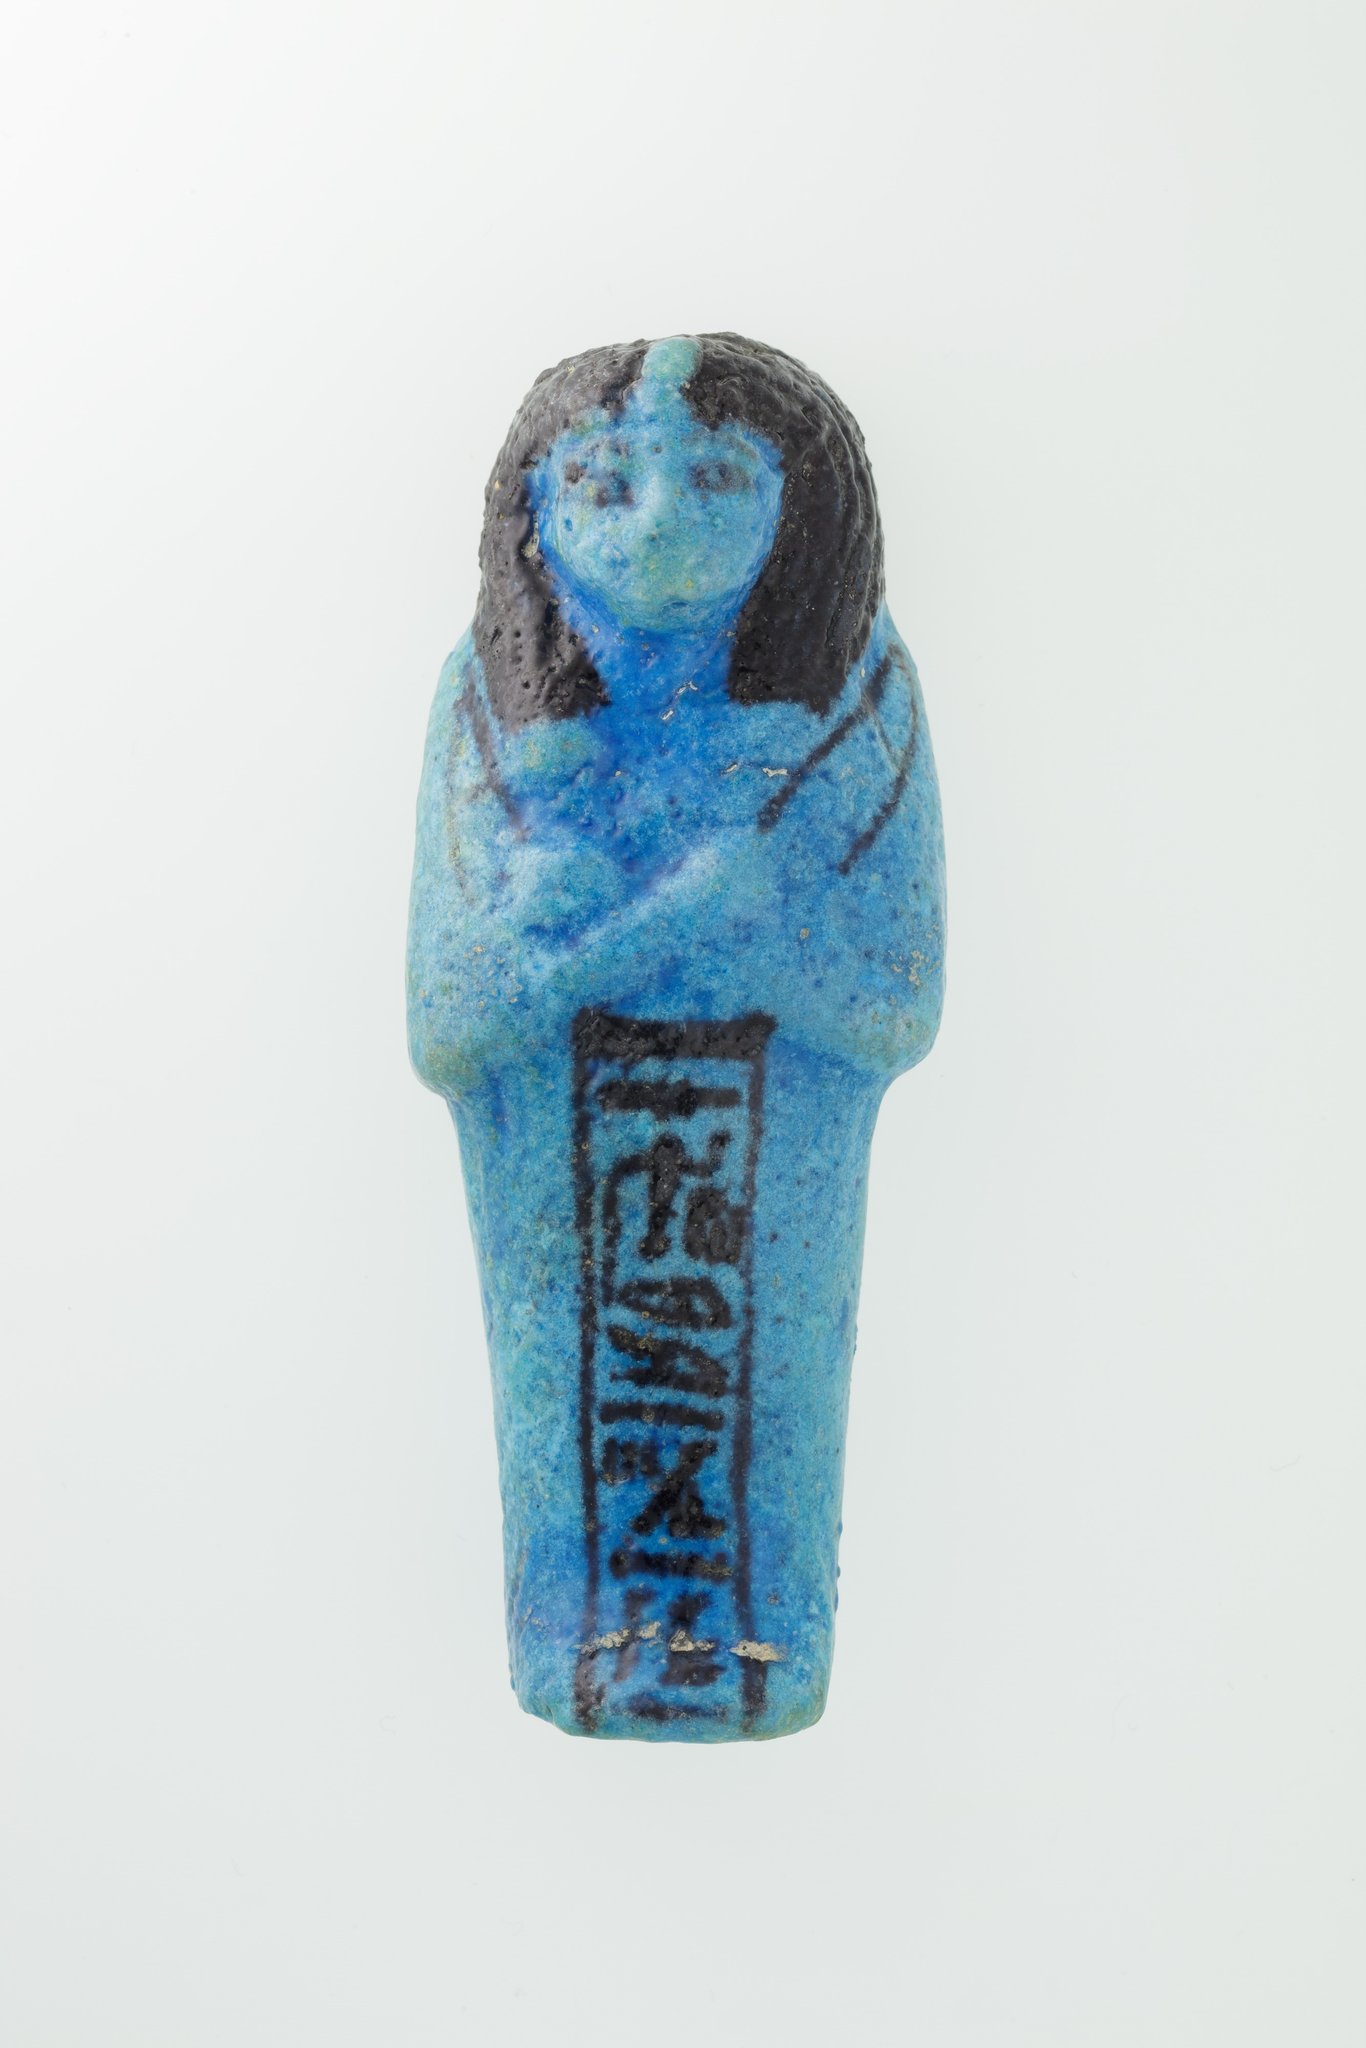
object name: shabti, worker, nauny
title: Worker Shabti of Nauny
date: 1050 BCE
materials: faience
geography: egypt